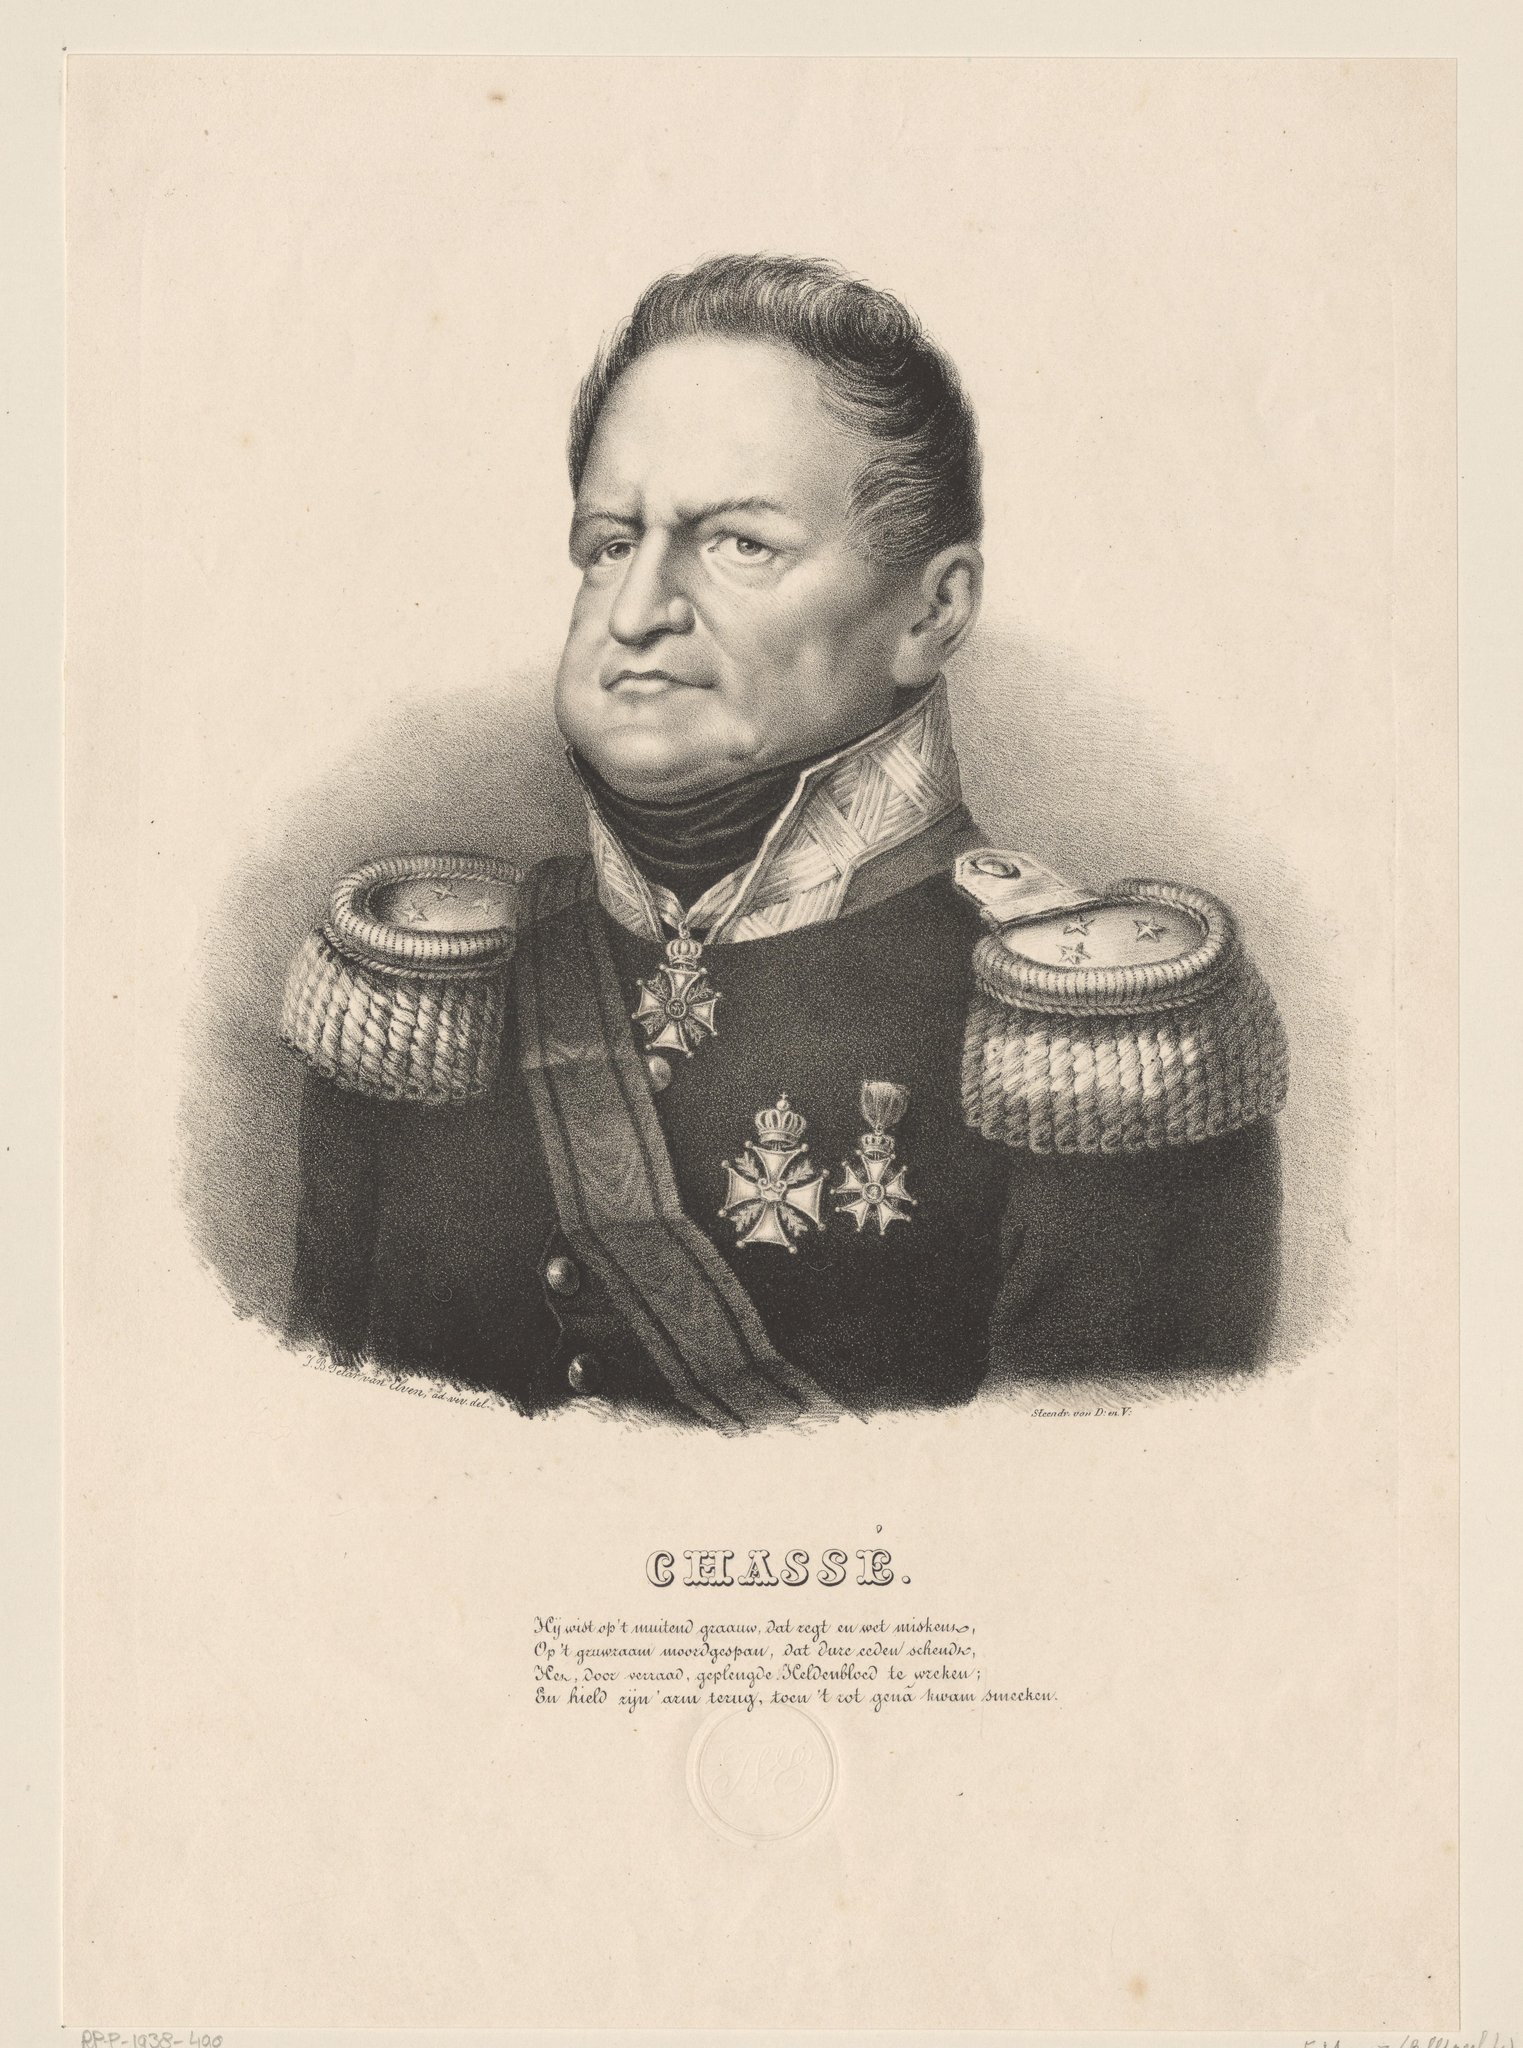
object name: print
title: Portret van David Hendrik baron Chassé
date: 1831-1832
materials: paper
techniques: lithograph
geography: amsterdam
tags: david hendrik baron chassé, commander-in-chief, general, marshal, historical persons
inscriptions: check stamp: ‘TVE’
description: Onder het portret een vierregelig vers over de Belgische opstand in 1830.